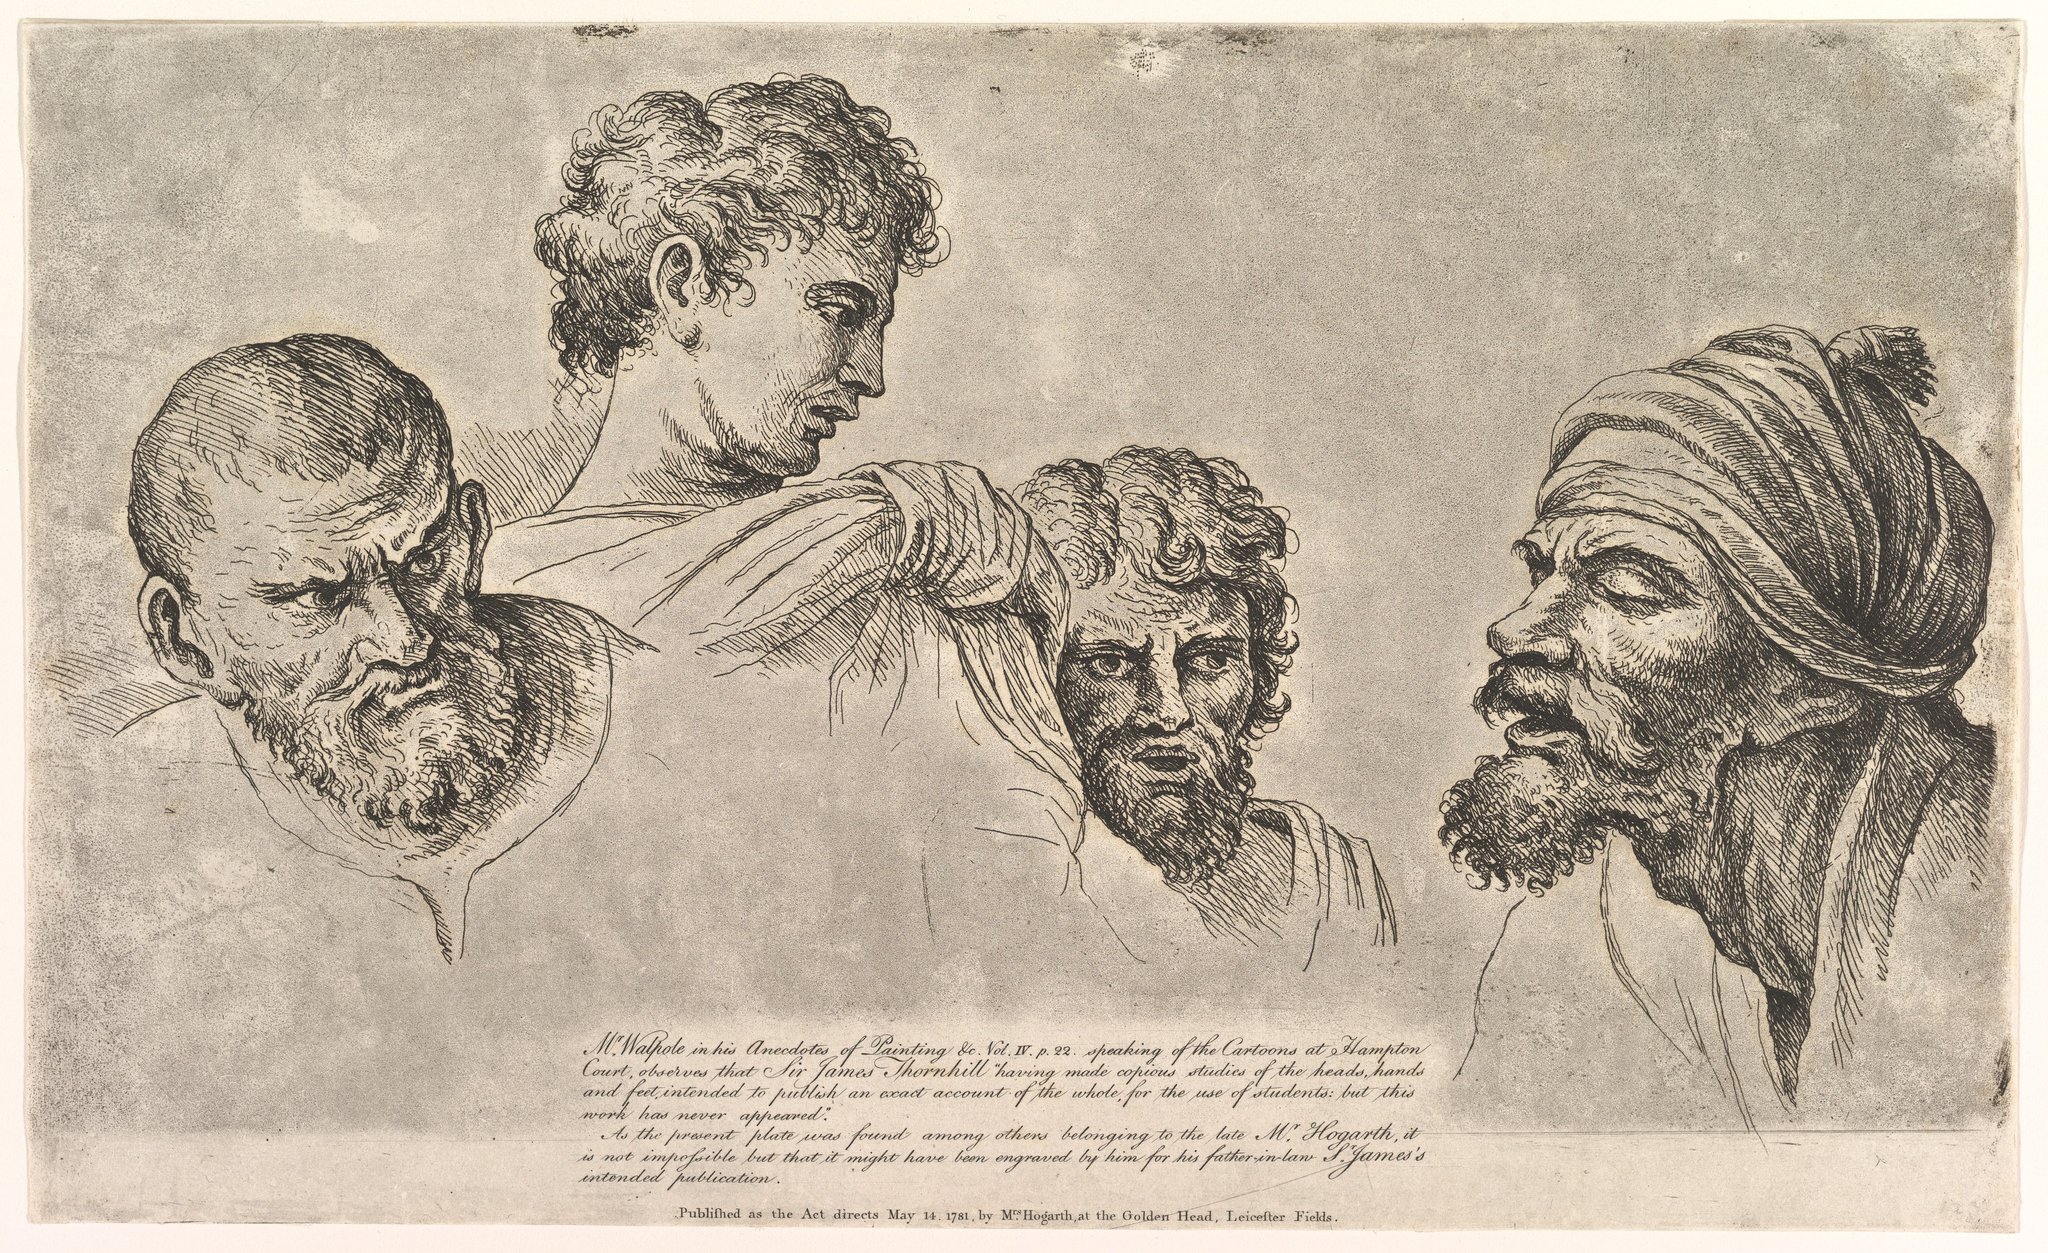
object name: print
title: Four Heads From the Raphael Cartoons at Hampton Court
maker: william hogarth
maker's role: artist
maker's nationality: british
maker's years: 1697-1764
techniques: aquatint, etching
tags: heads,men